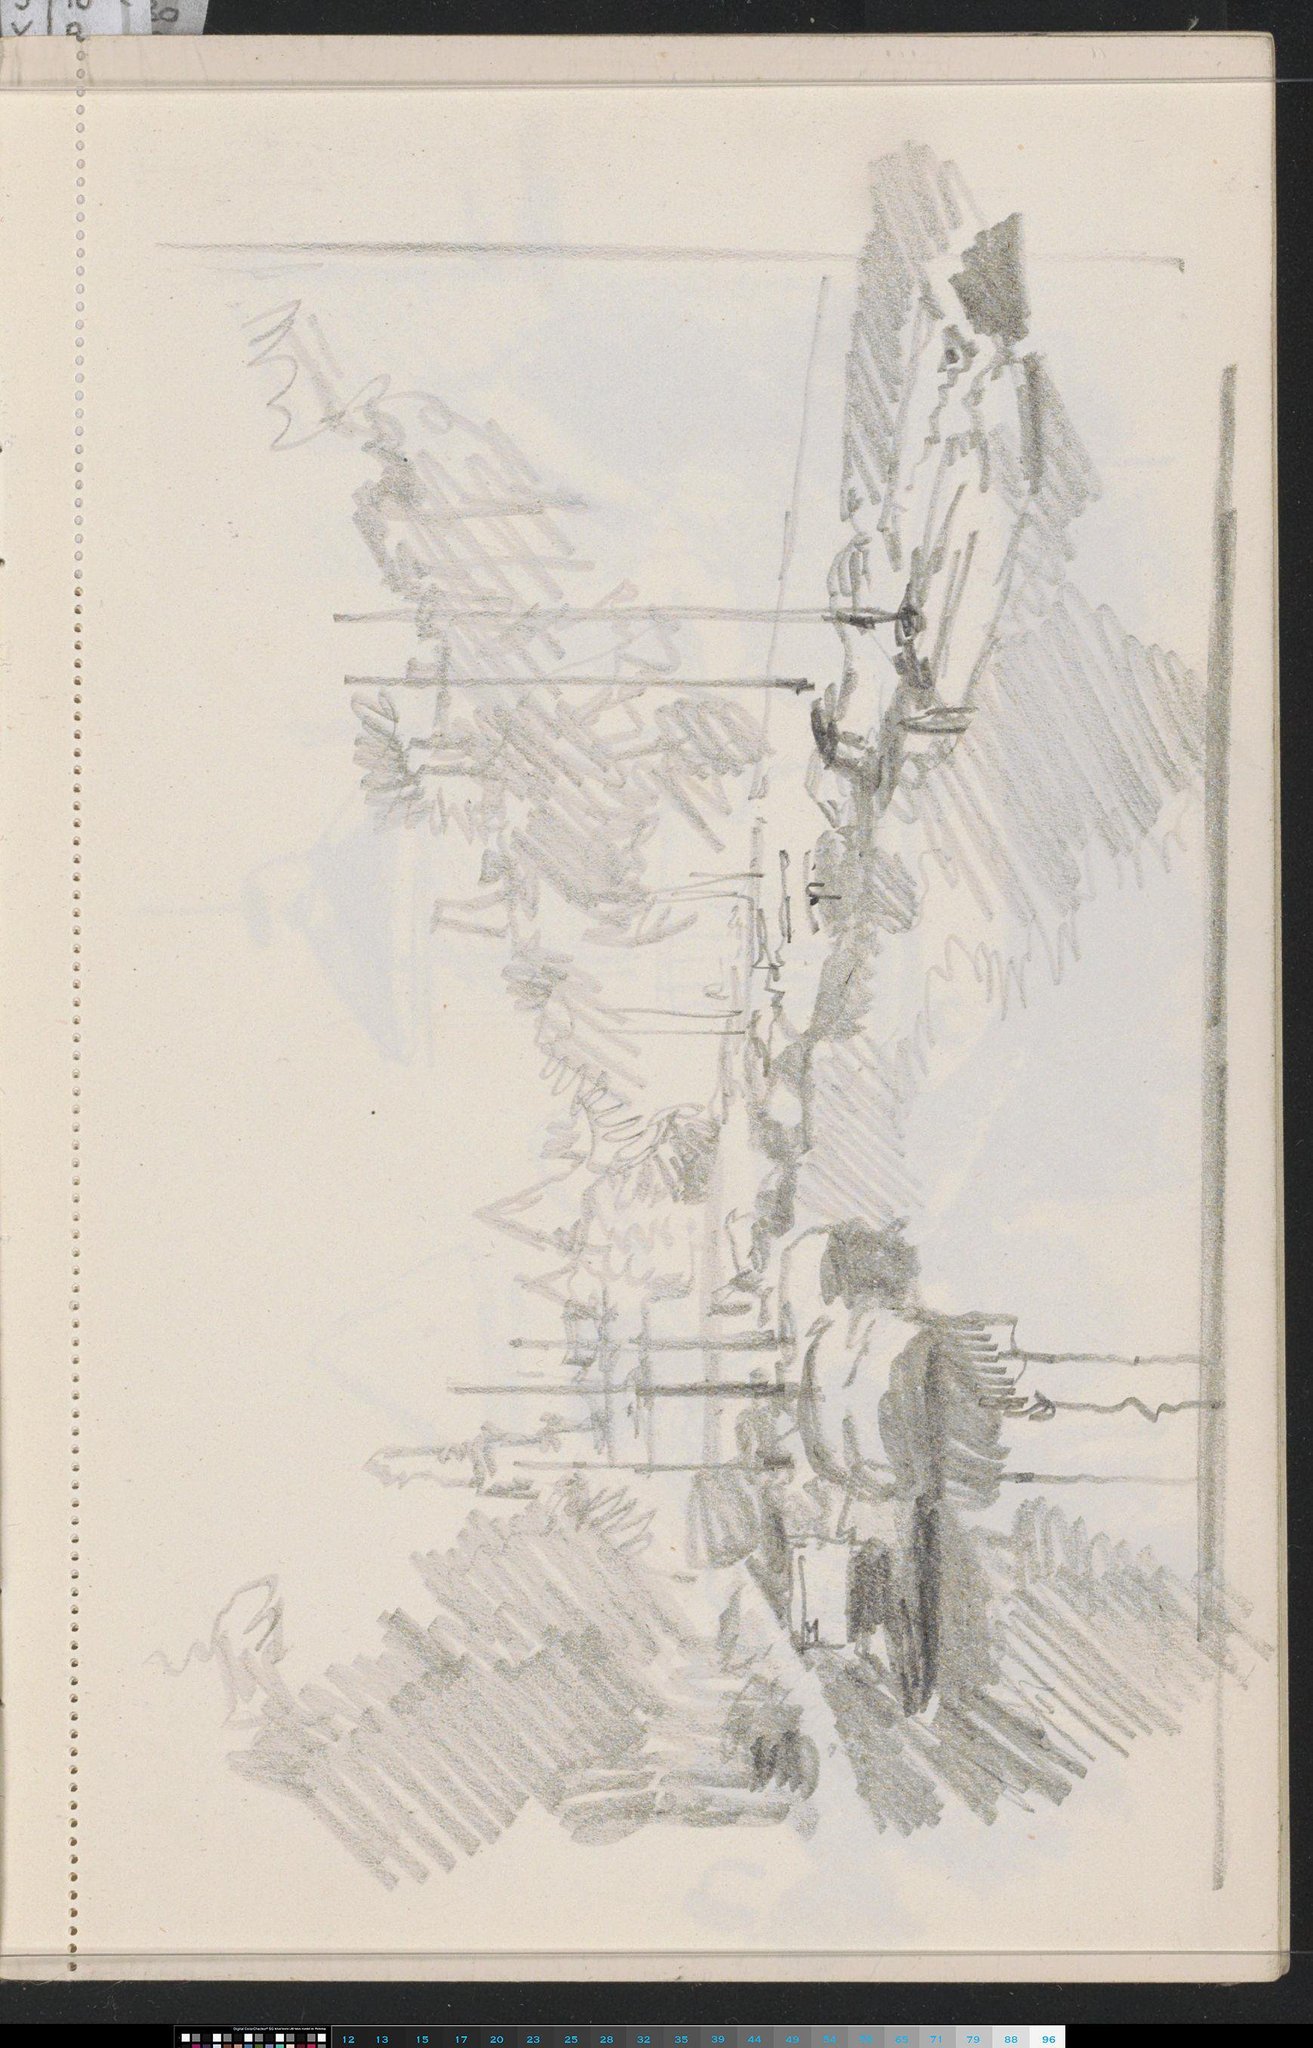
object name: sketchbook leaf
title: Gracht met aangemeerde zeilschepen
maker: cornelis vreedenburgh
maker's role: draughtsman, print maker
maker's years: 1880-1946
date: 1935-1936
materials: paper, pencil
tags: sailing-ship, sailing-boat, canals, waters (in city)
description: Blad 9 recto uit een schetsboek met 73 bladen.